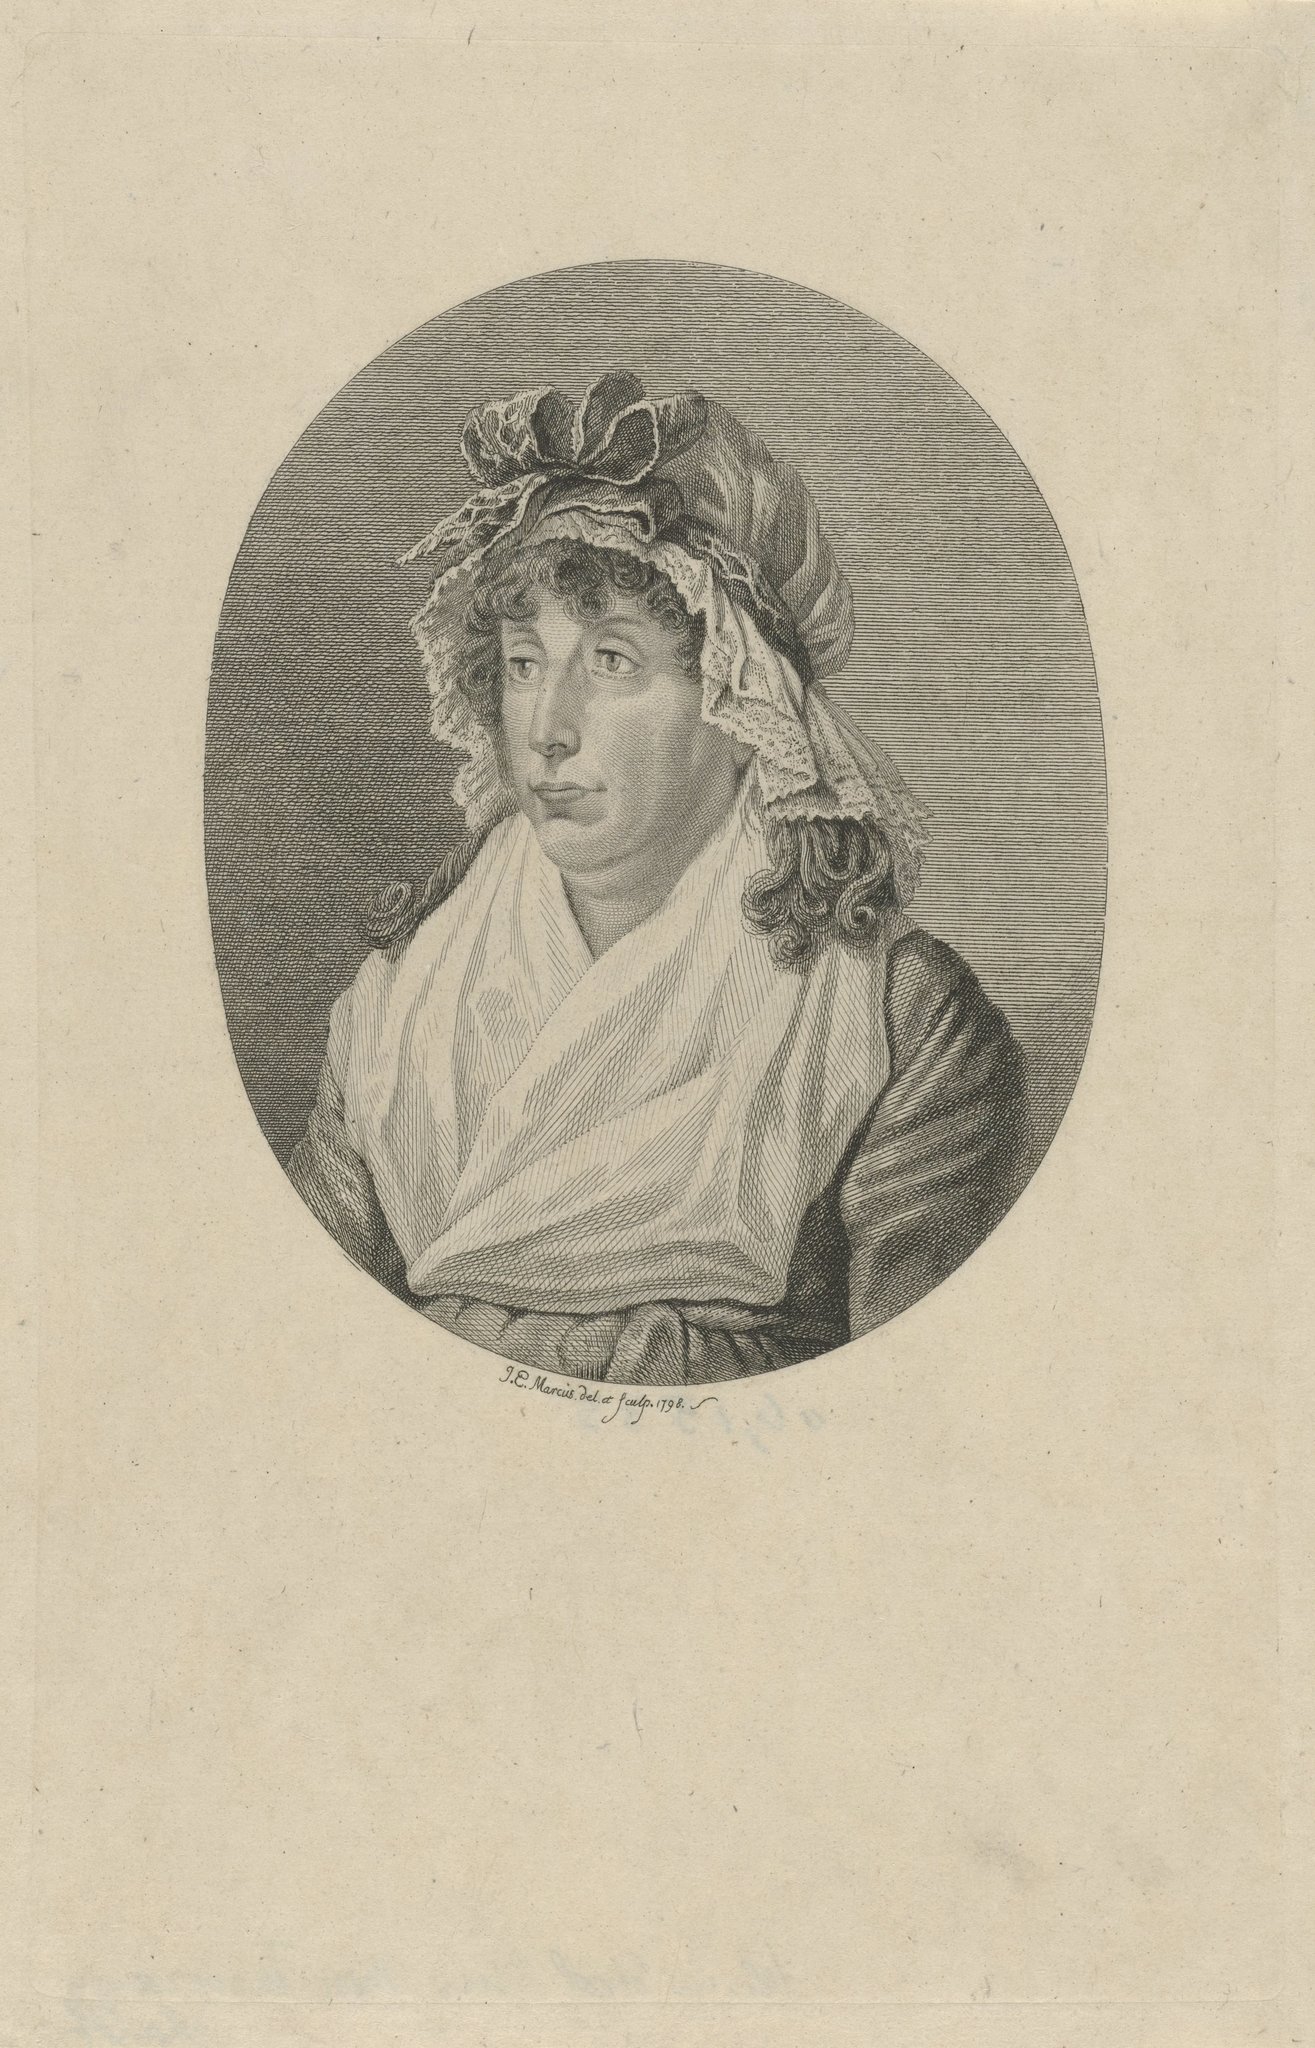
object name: print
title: Portret van Anna Maria Taunay-Scharff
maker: jacob ernst marcus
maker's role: draughtsman, print maker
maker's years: 1774-1826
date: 1798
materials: paper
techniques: etching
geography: amsterdam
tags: anna maria taunay-scharff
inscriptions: collector's mark: Lugt 2228